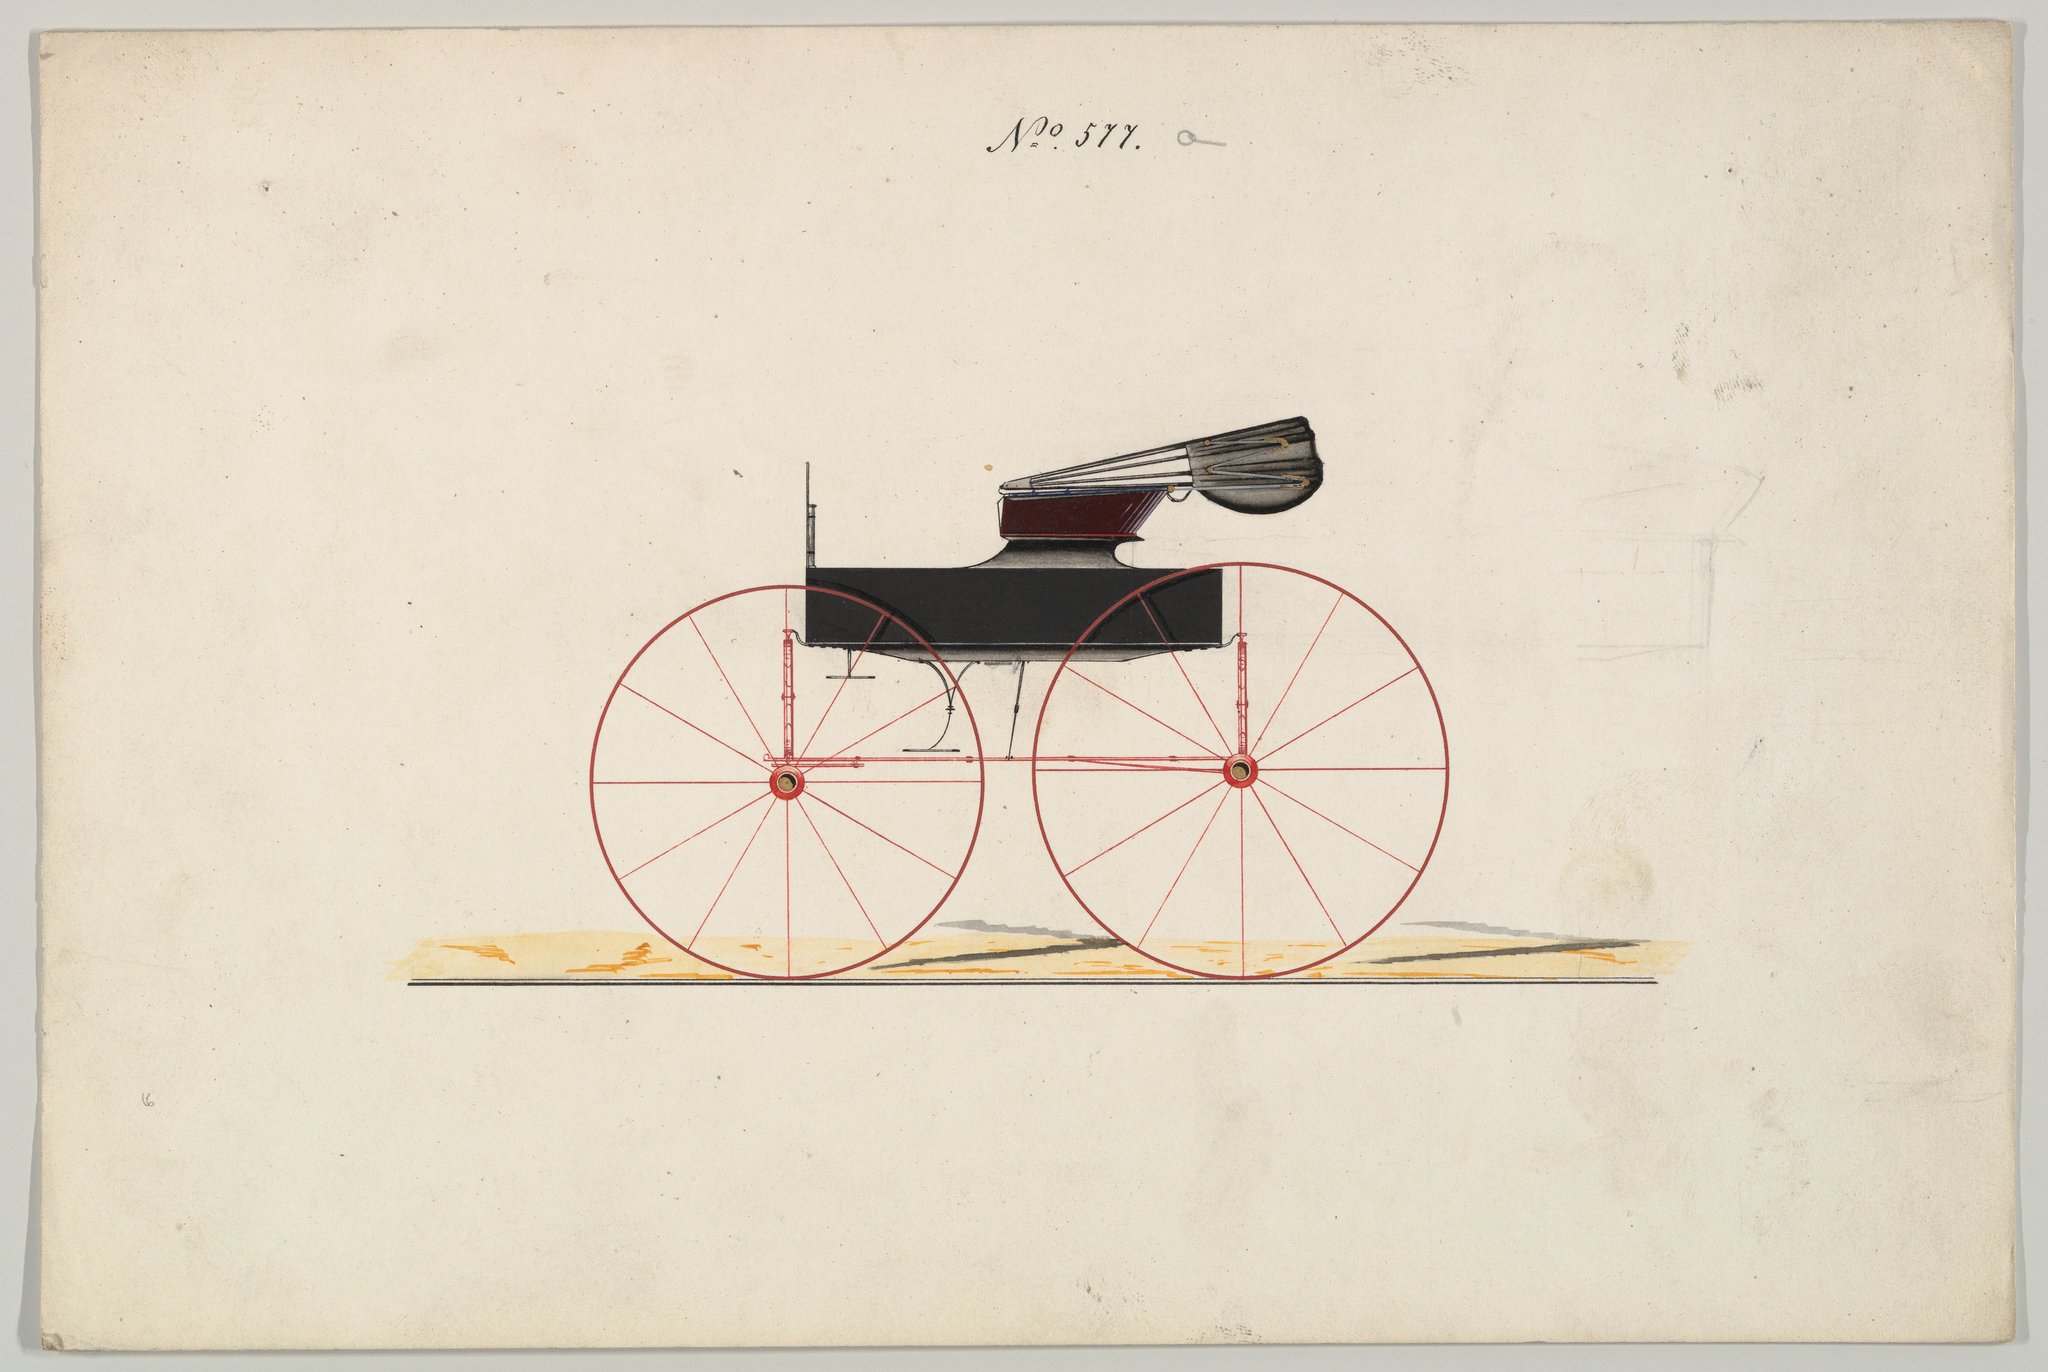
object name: drawing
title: Wagon # 577a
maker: brewster & co.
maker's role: manufacturer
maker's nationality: american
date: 1865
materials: gouache, gum arabic, ink, watercolor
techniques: pen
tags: carriages